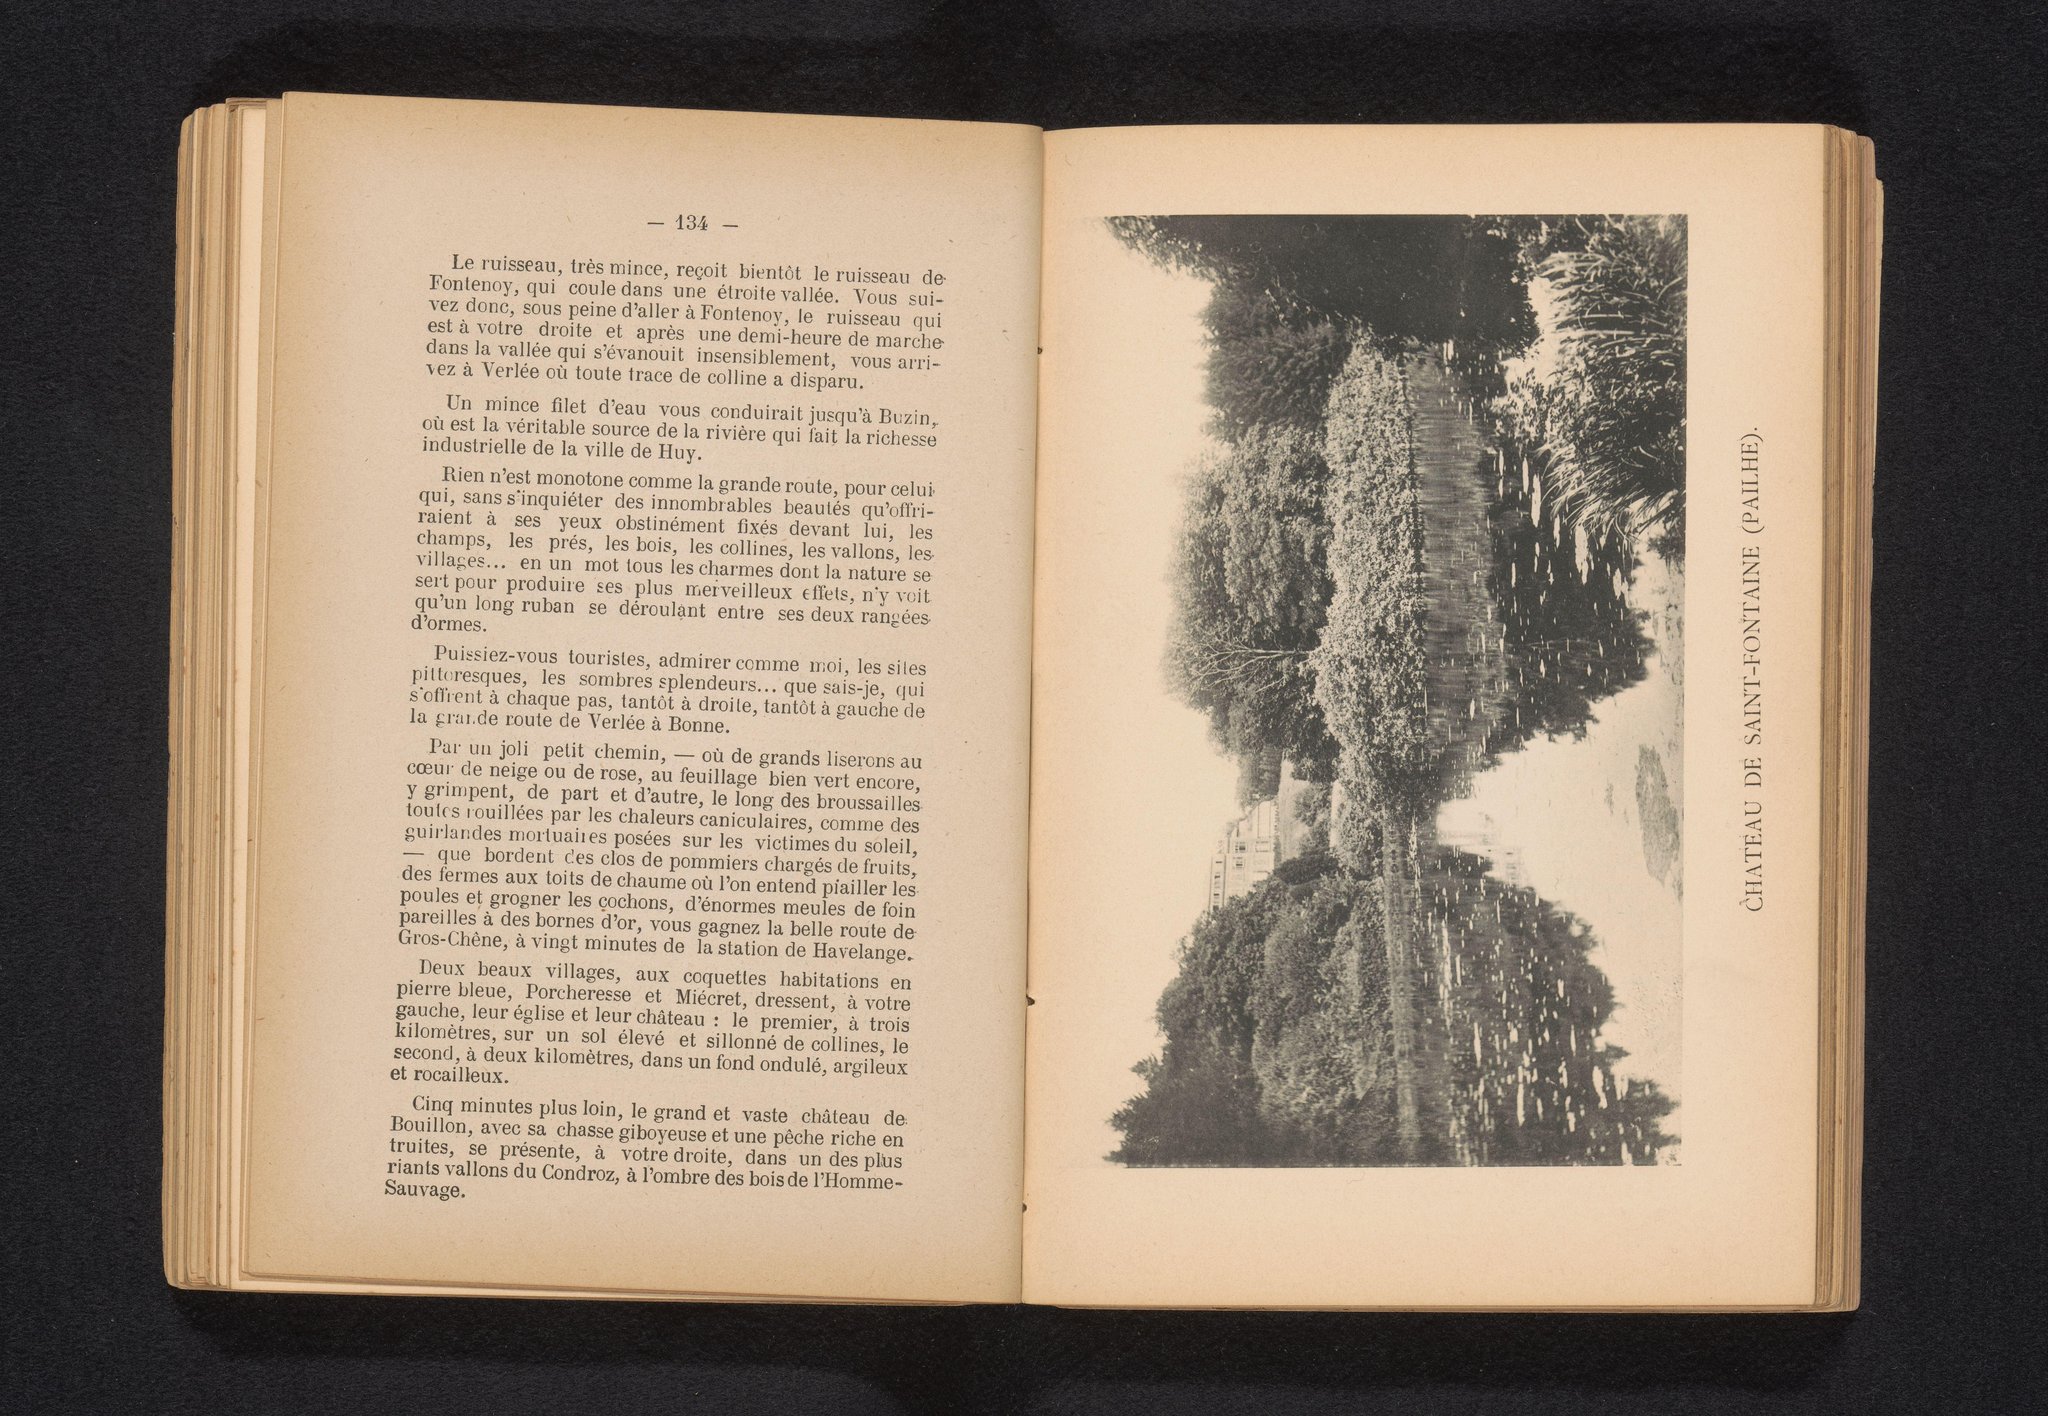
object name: photomechanical print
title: Landschap met Château de Saint-Fontaine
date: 1885-1890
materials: paper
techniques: photograph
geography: brussels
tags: castle, liège